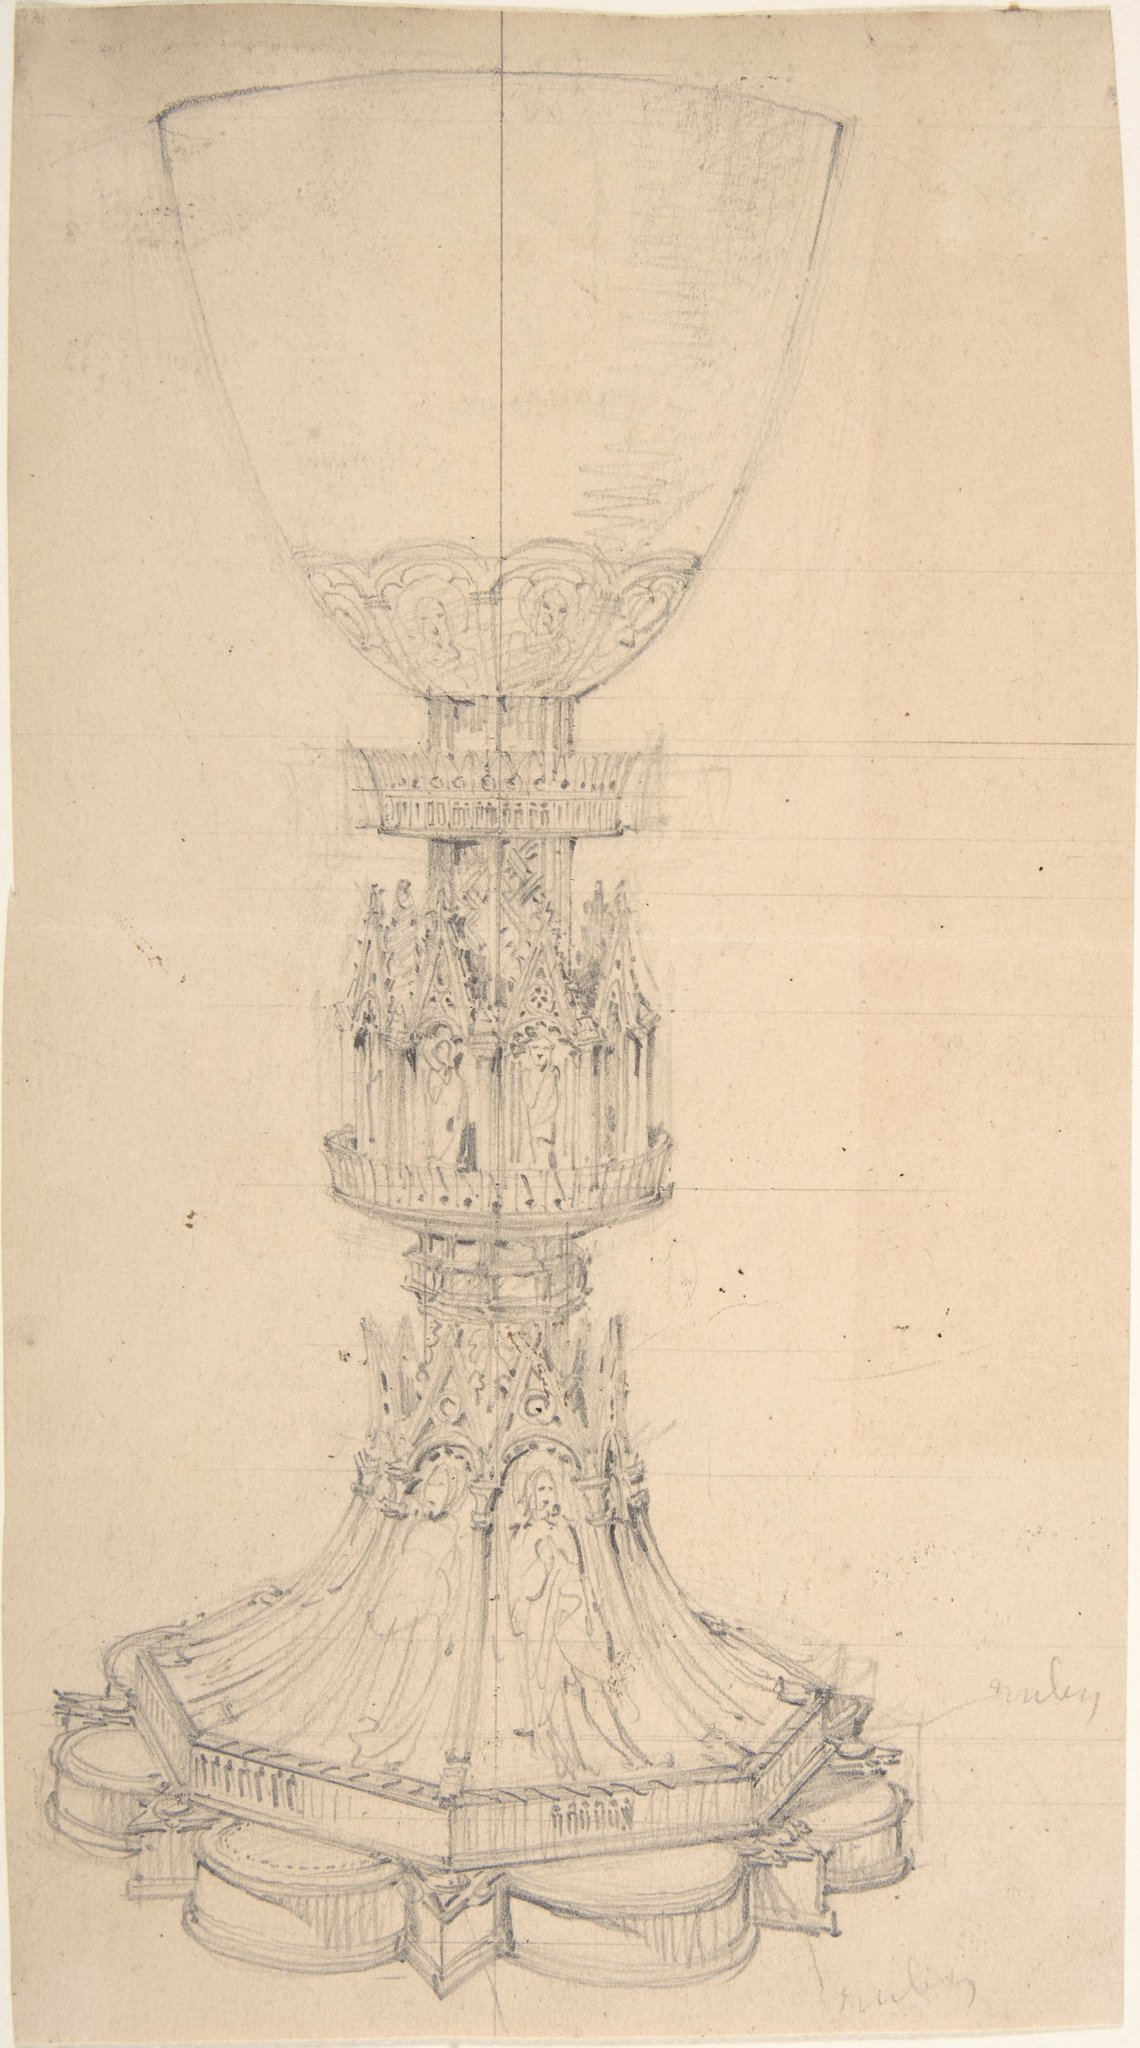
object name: drawing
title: Chalice adorned with Saints, BIshops and Kings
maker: anonymous, british, 19th century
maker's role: artist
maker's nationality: british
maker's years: 1800-1900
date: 1851-1900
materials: graphite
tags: chalices